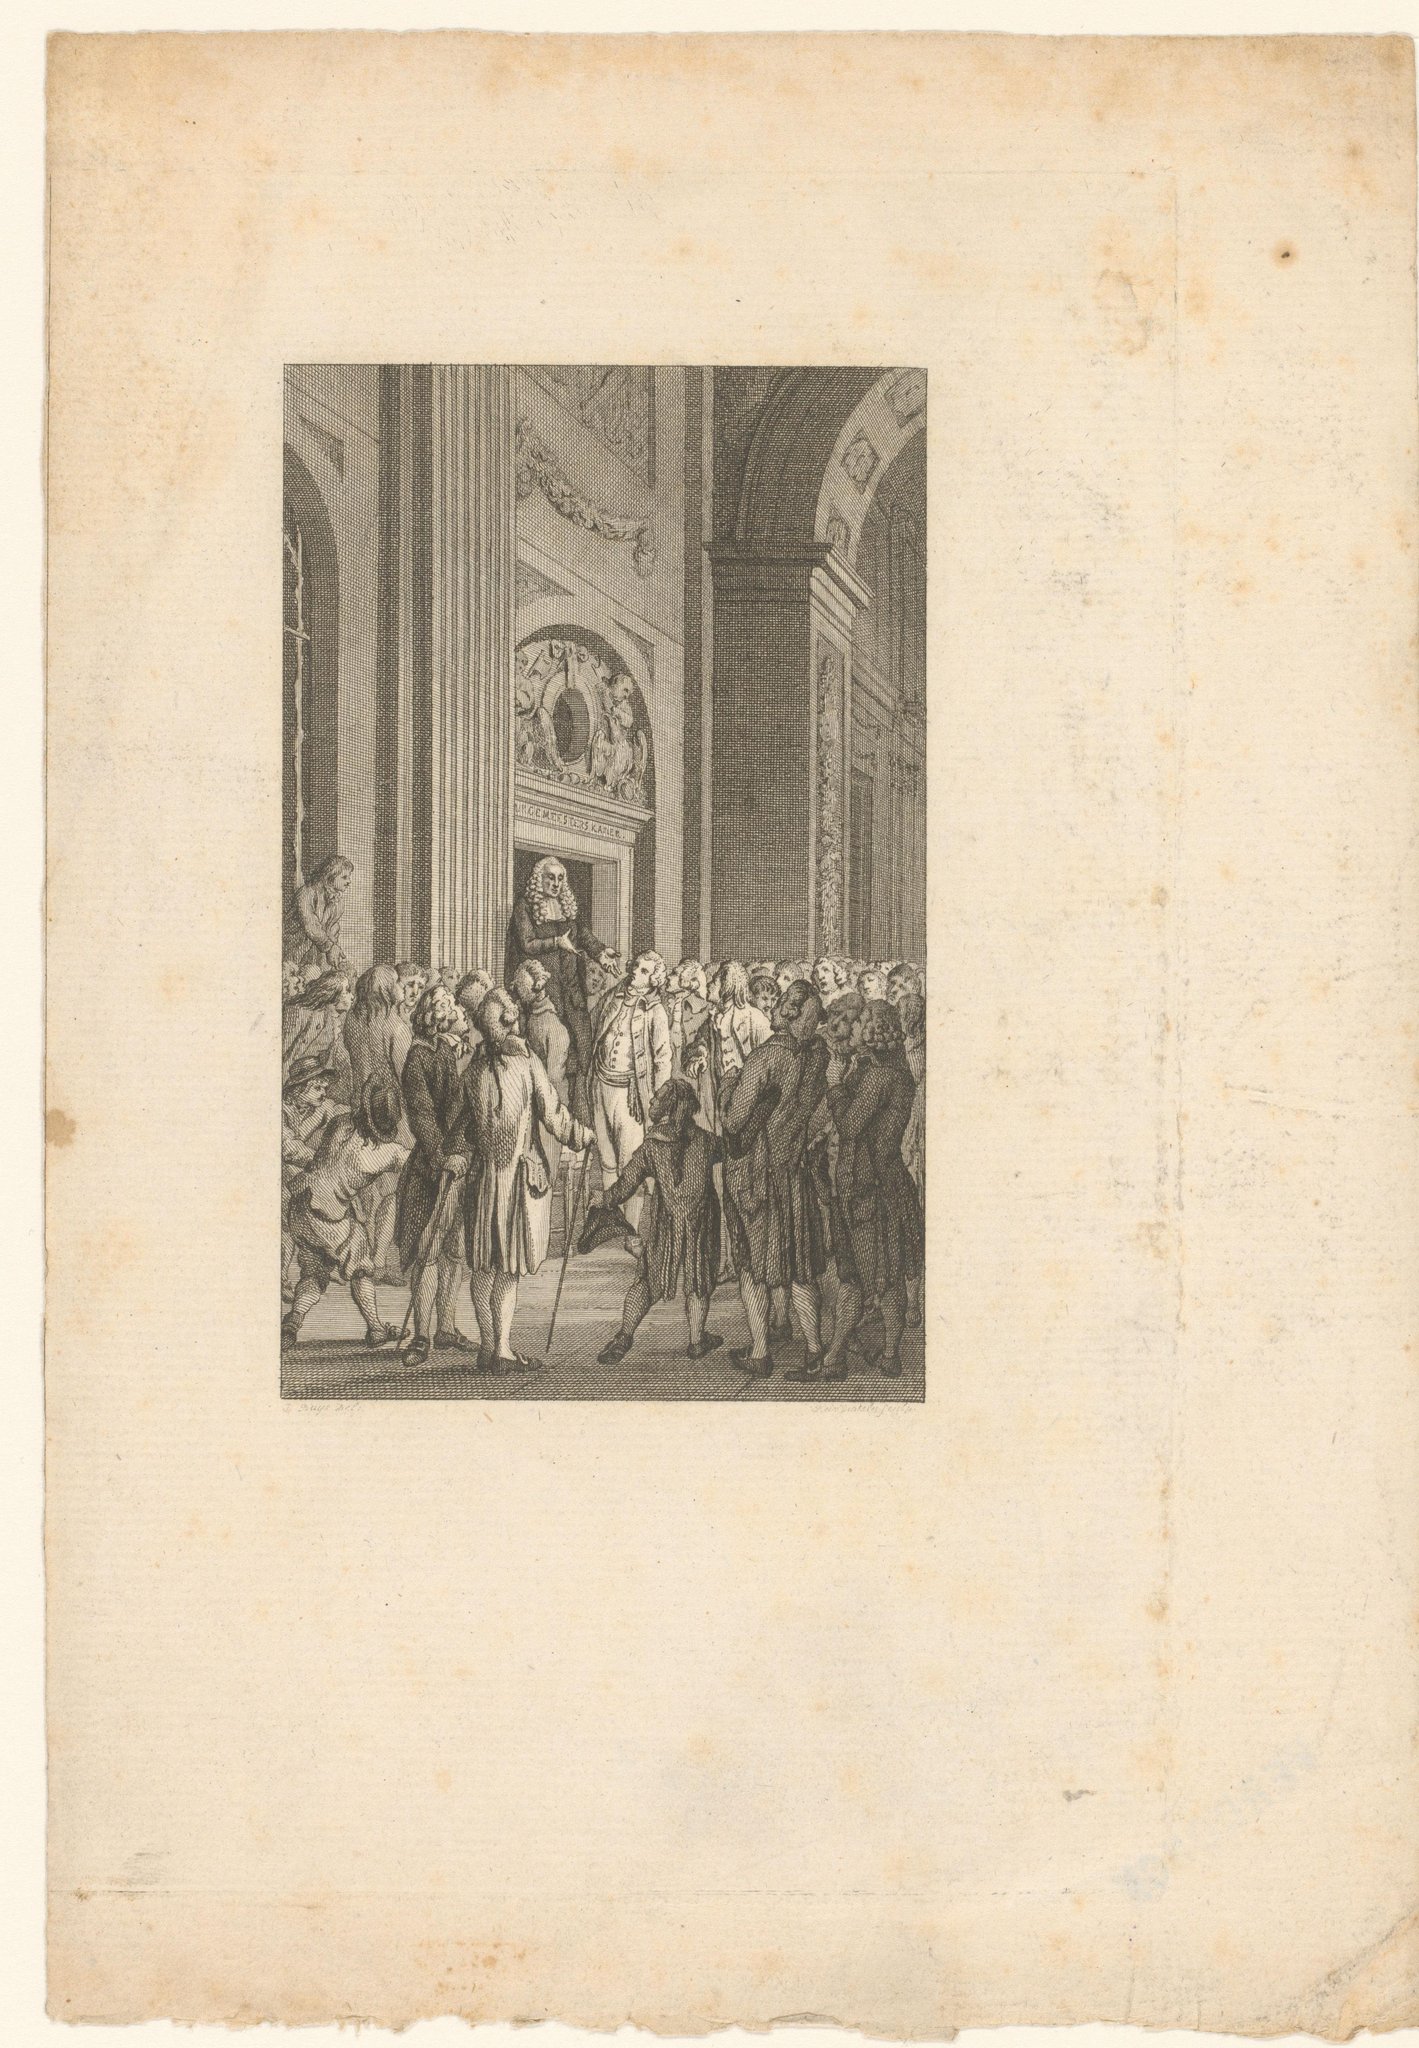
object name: print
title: Burgemeester Hendrik Hooft Danielsz onderhandelt met de burgerij, 1787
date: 1796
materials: paper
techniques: etching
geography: northern netherlands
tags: amsterdam, mayor, hendrik danielsz. hooft, rijngraaf van salm frederik iii, crowd, mob, mayor, burgomaster, person addressing a group, orator, patriots (1780-1795)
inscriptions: collector's mark: ‘VERDONCK’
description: De Amsterdamse burgemeester Hendrik Danielsz. Hooft onderhandelt met de burgerij over het afdanken van de Rijngraaf van Salm, 26 februari 1787. Hooft spreekt staande voor de ingang van de burgemeesterskamer in het Stadhuis de samengestroomde burgers toe.